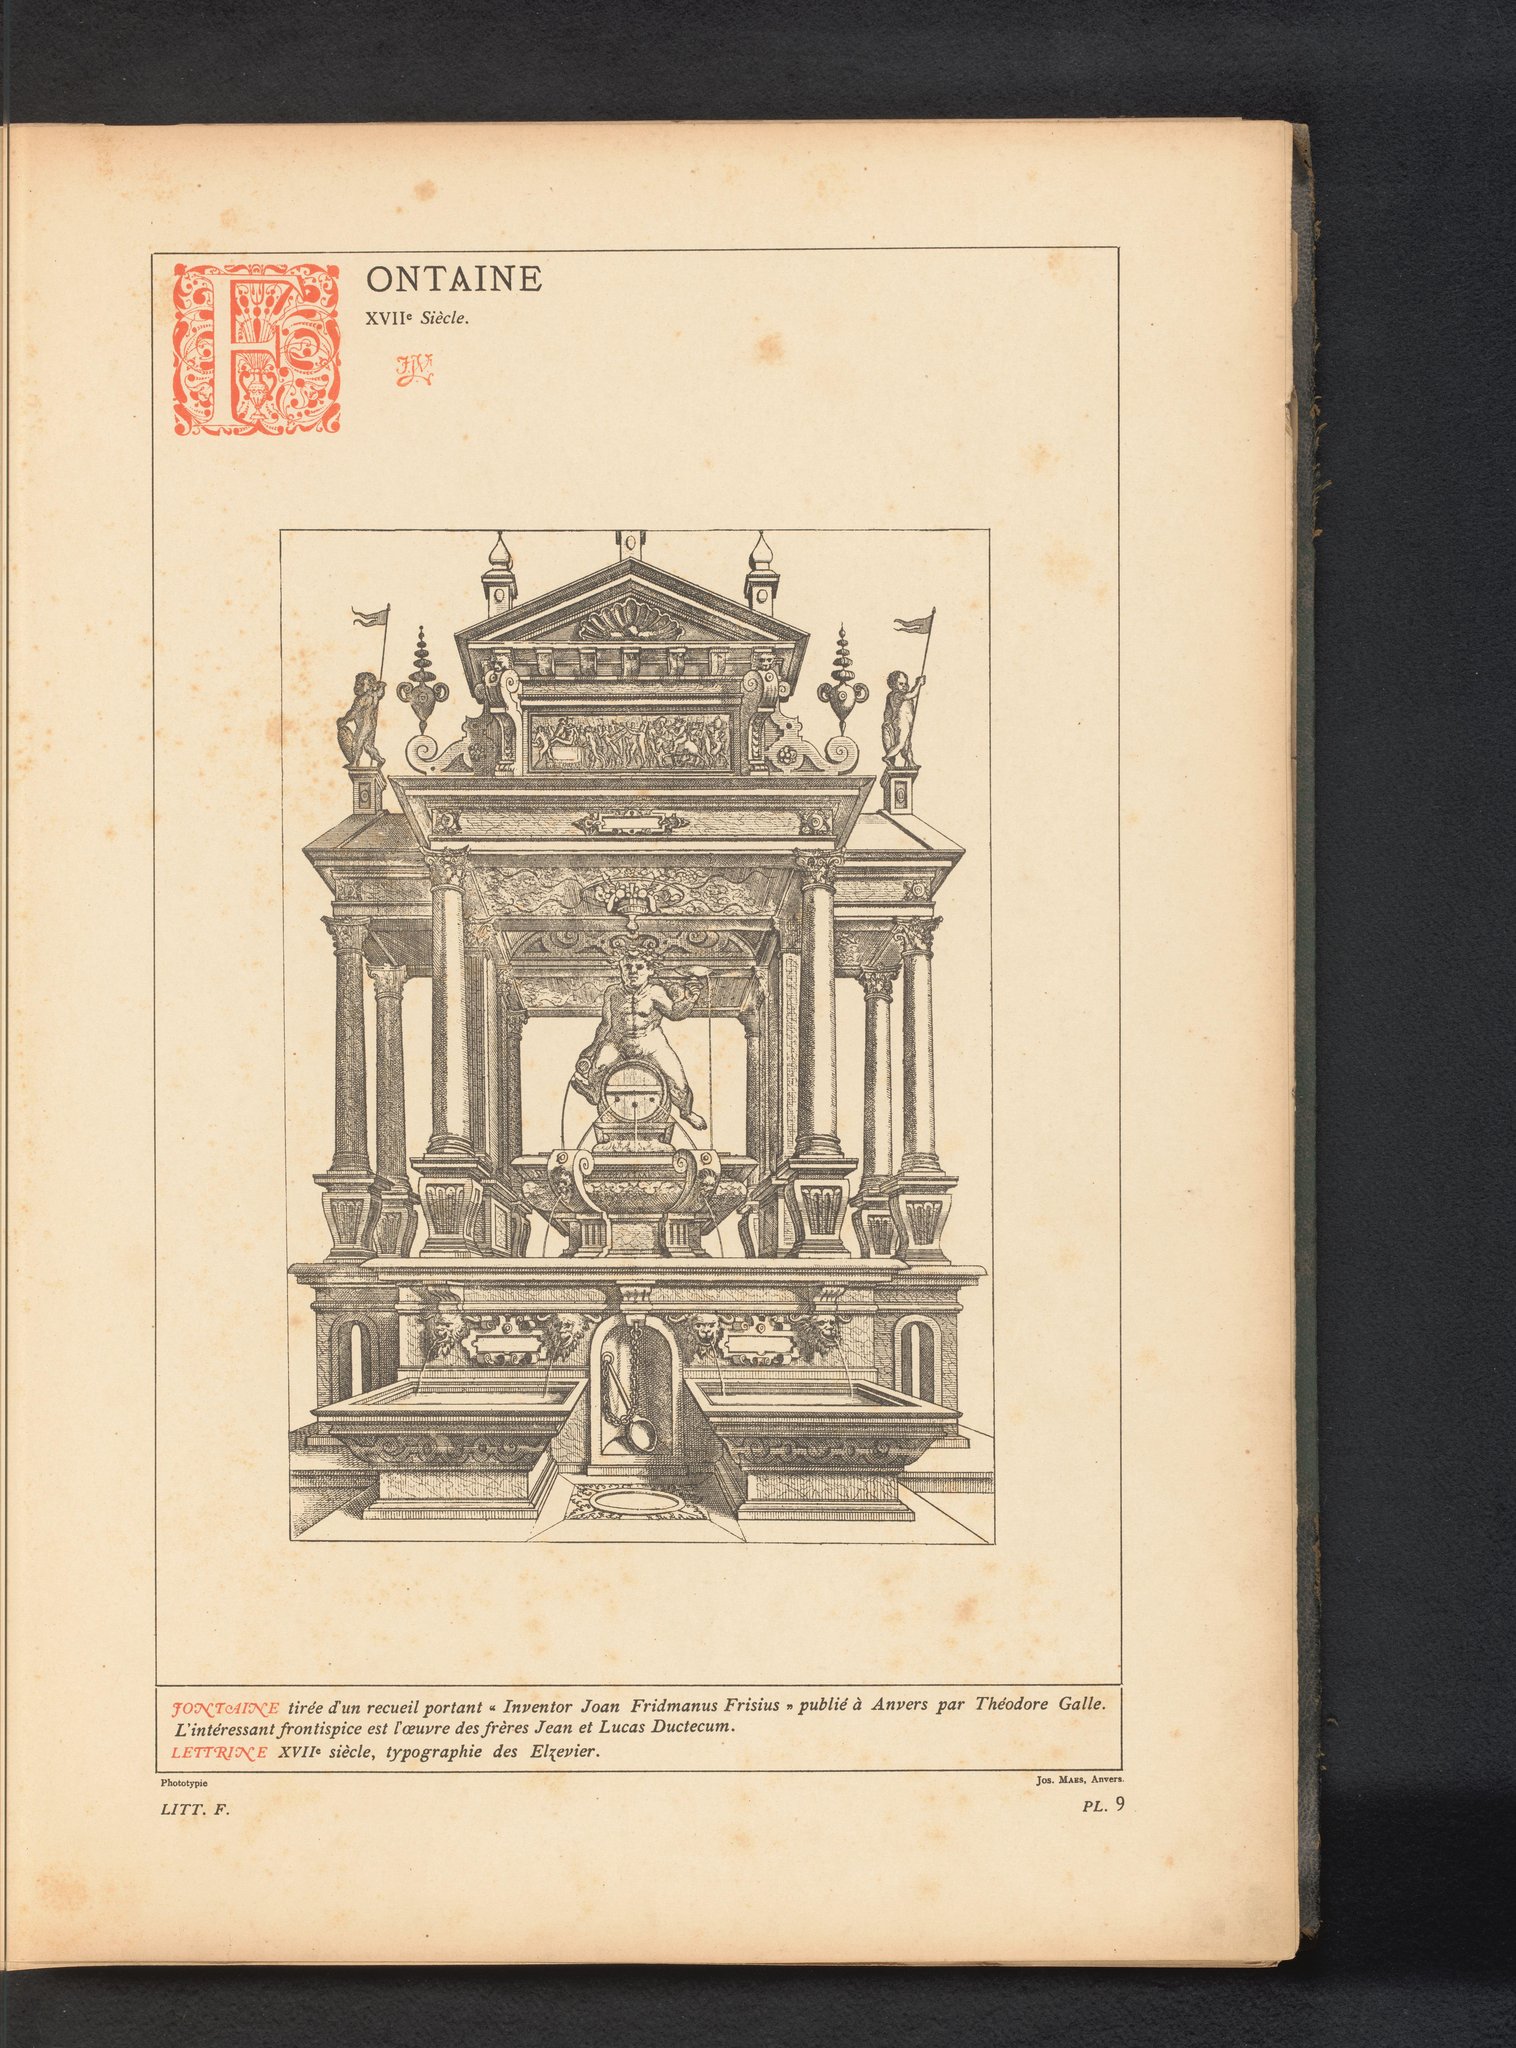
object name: photomechanical print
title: Reproductie van een prent van een fontein in de vorm van een Romeinse tempel door Johannes of Lucas van Doetechum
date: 1875-1880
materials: paper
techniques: photolithography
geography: antwerp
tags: temple, shrine ~ roman religion, ornamental fountain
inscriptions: inscription: ‘LITT. F. - PL. 9’, monogram: ‘JJvY’, inscription: ‘FONTAINE tirée d'un (...)’